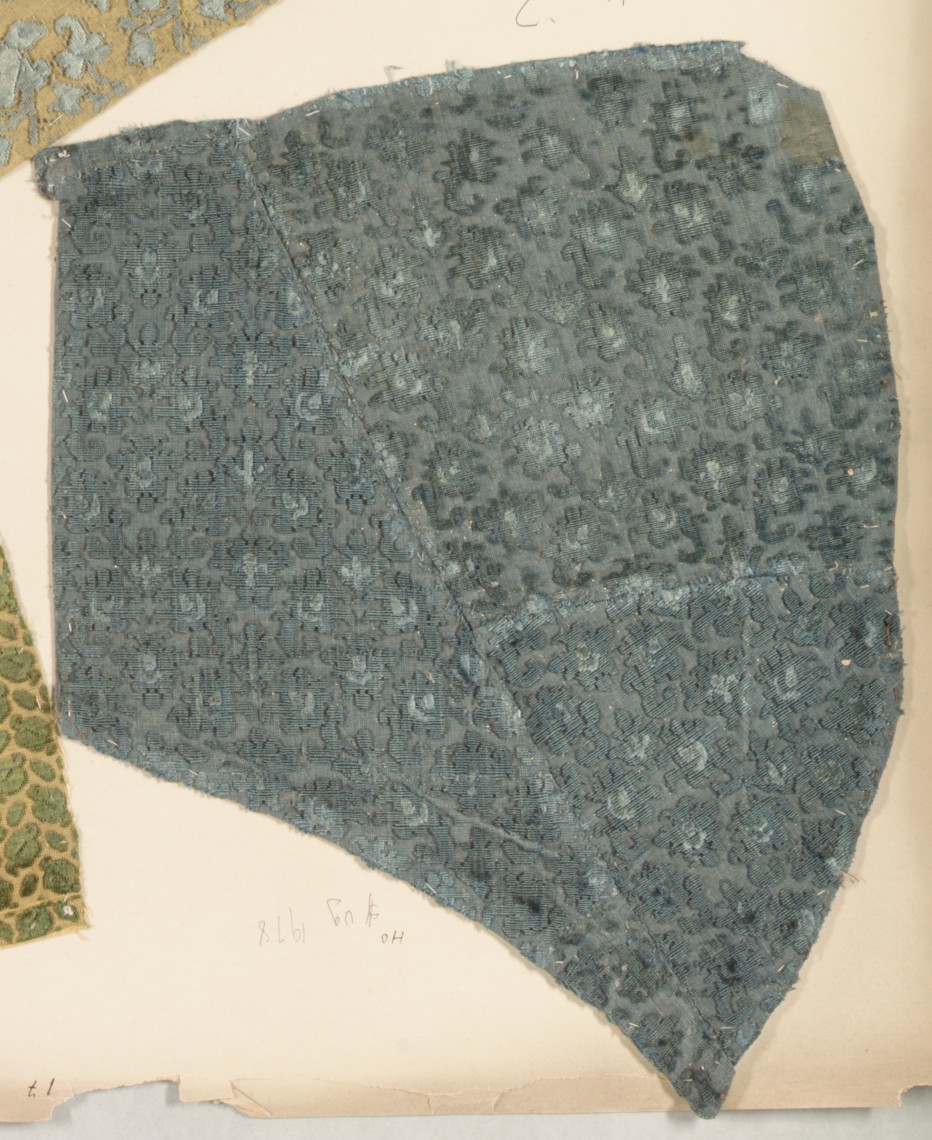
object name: fragment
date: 1501-1600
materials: metal thread, silk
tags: flowers